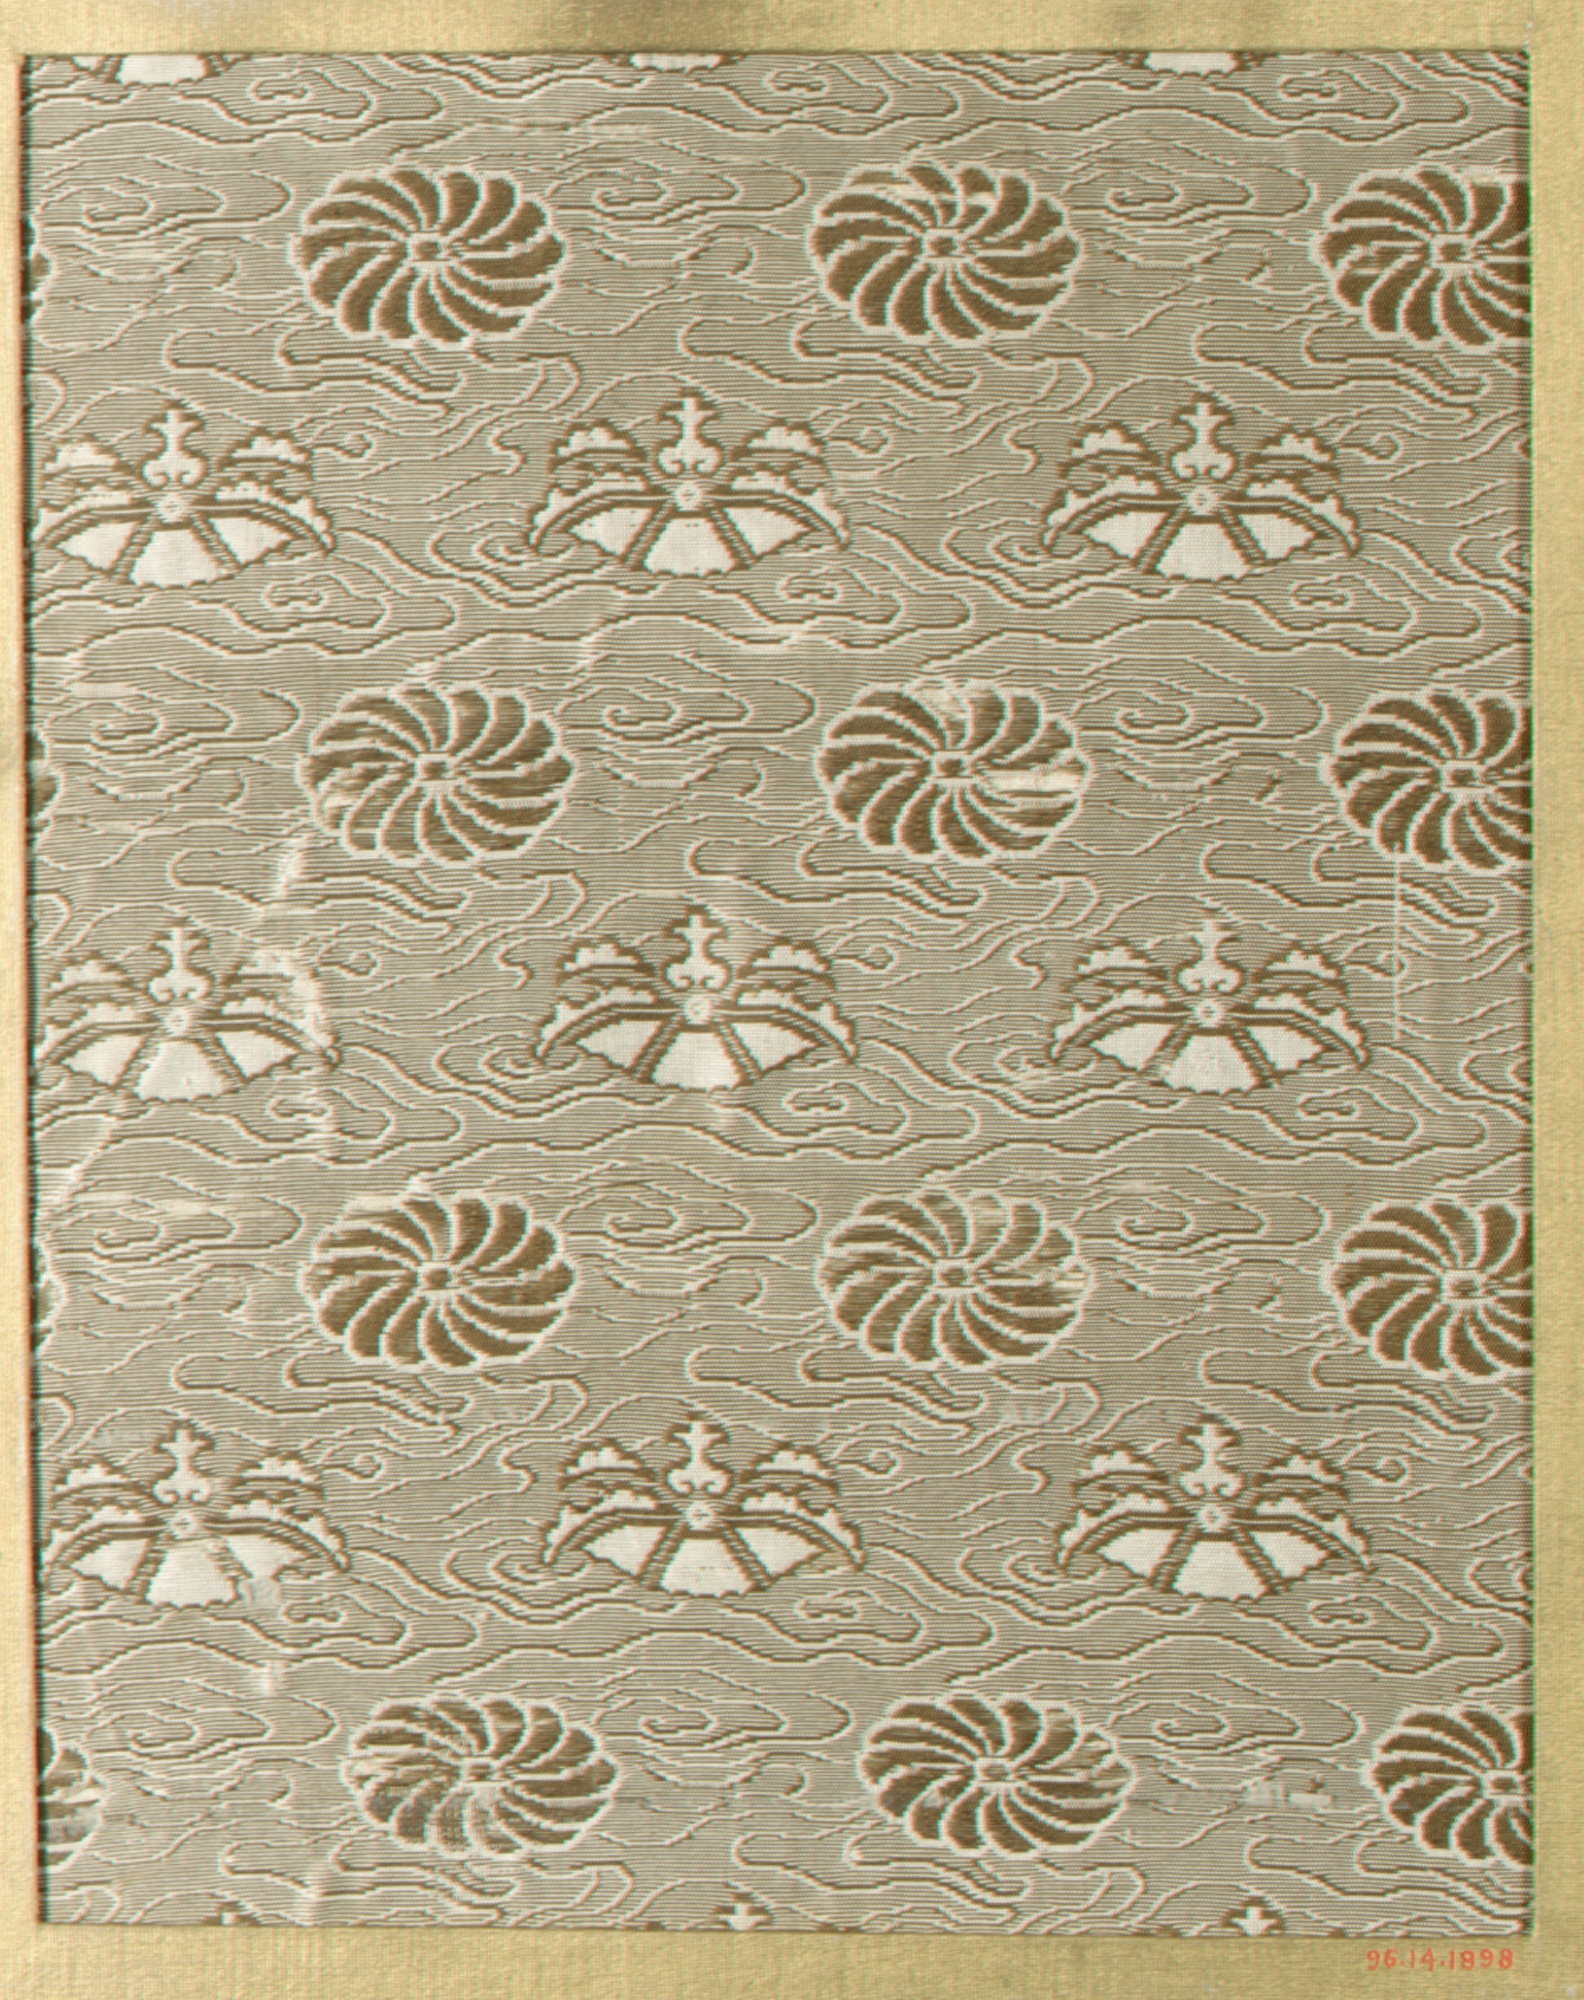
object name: piece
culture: japanese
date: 1701-1900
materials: silk